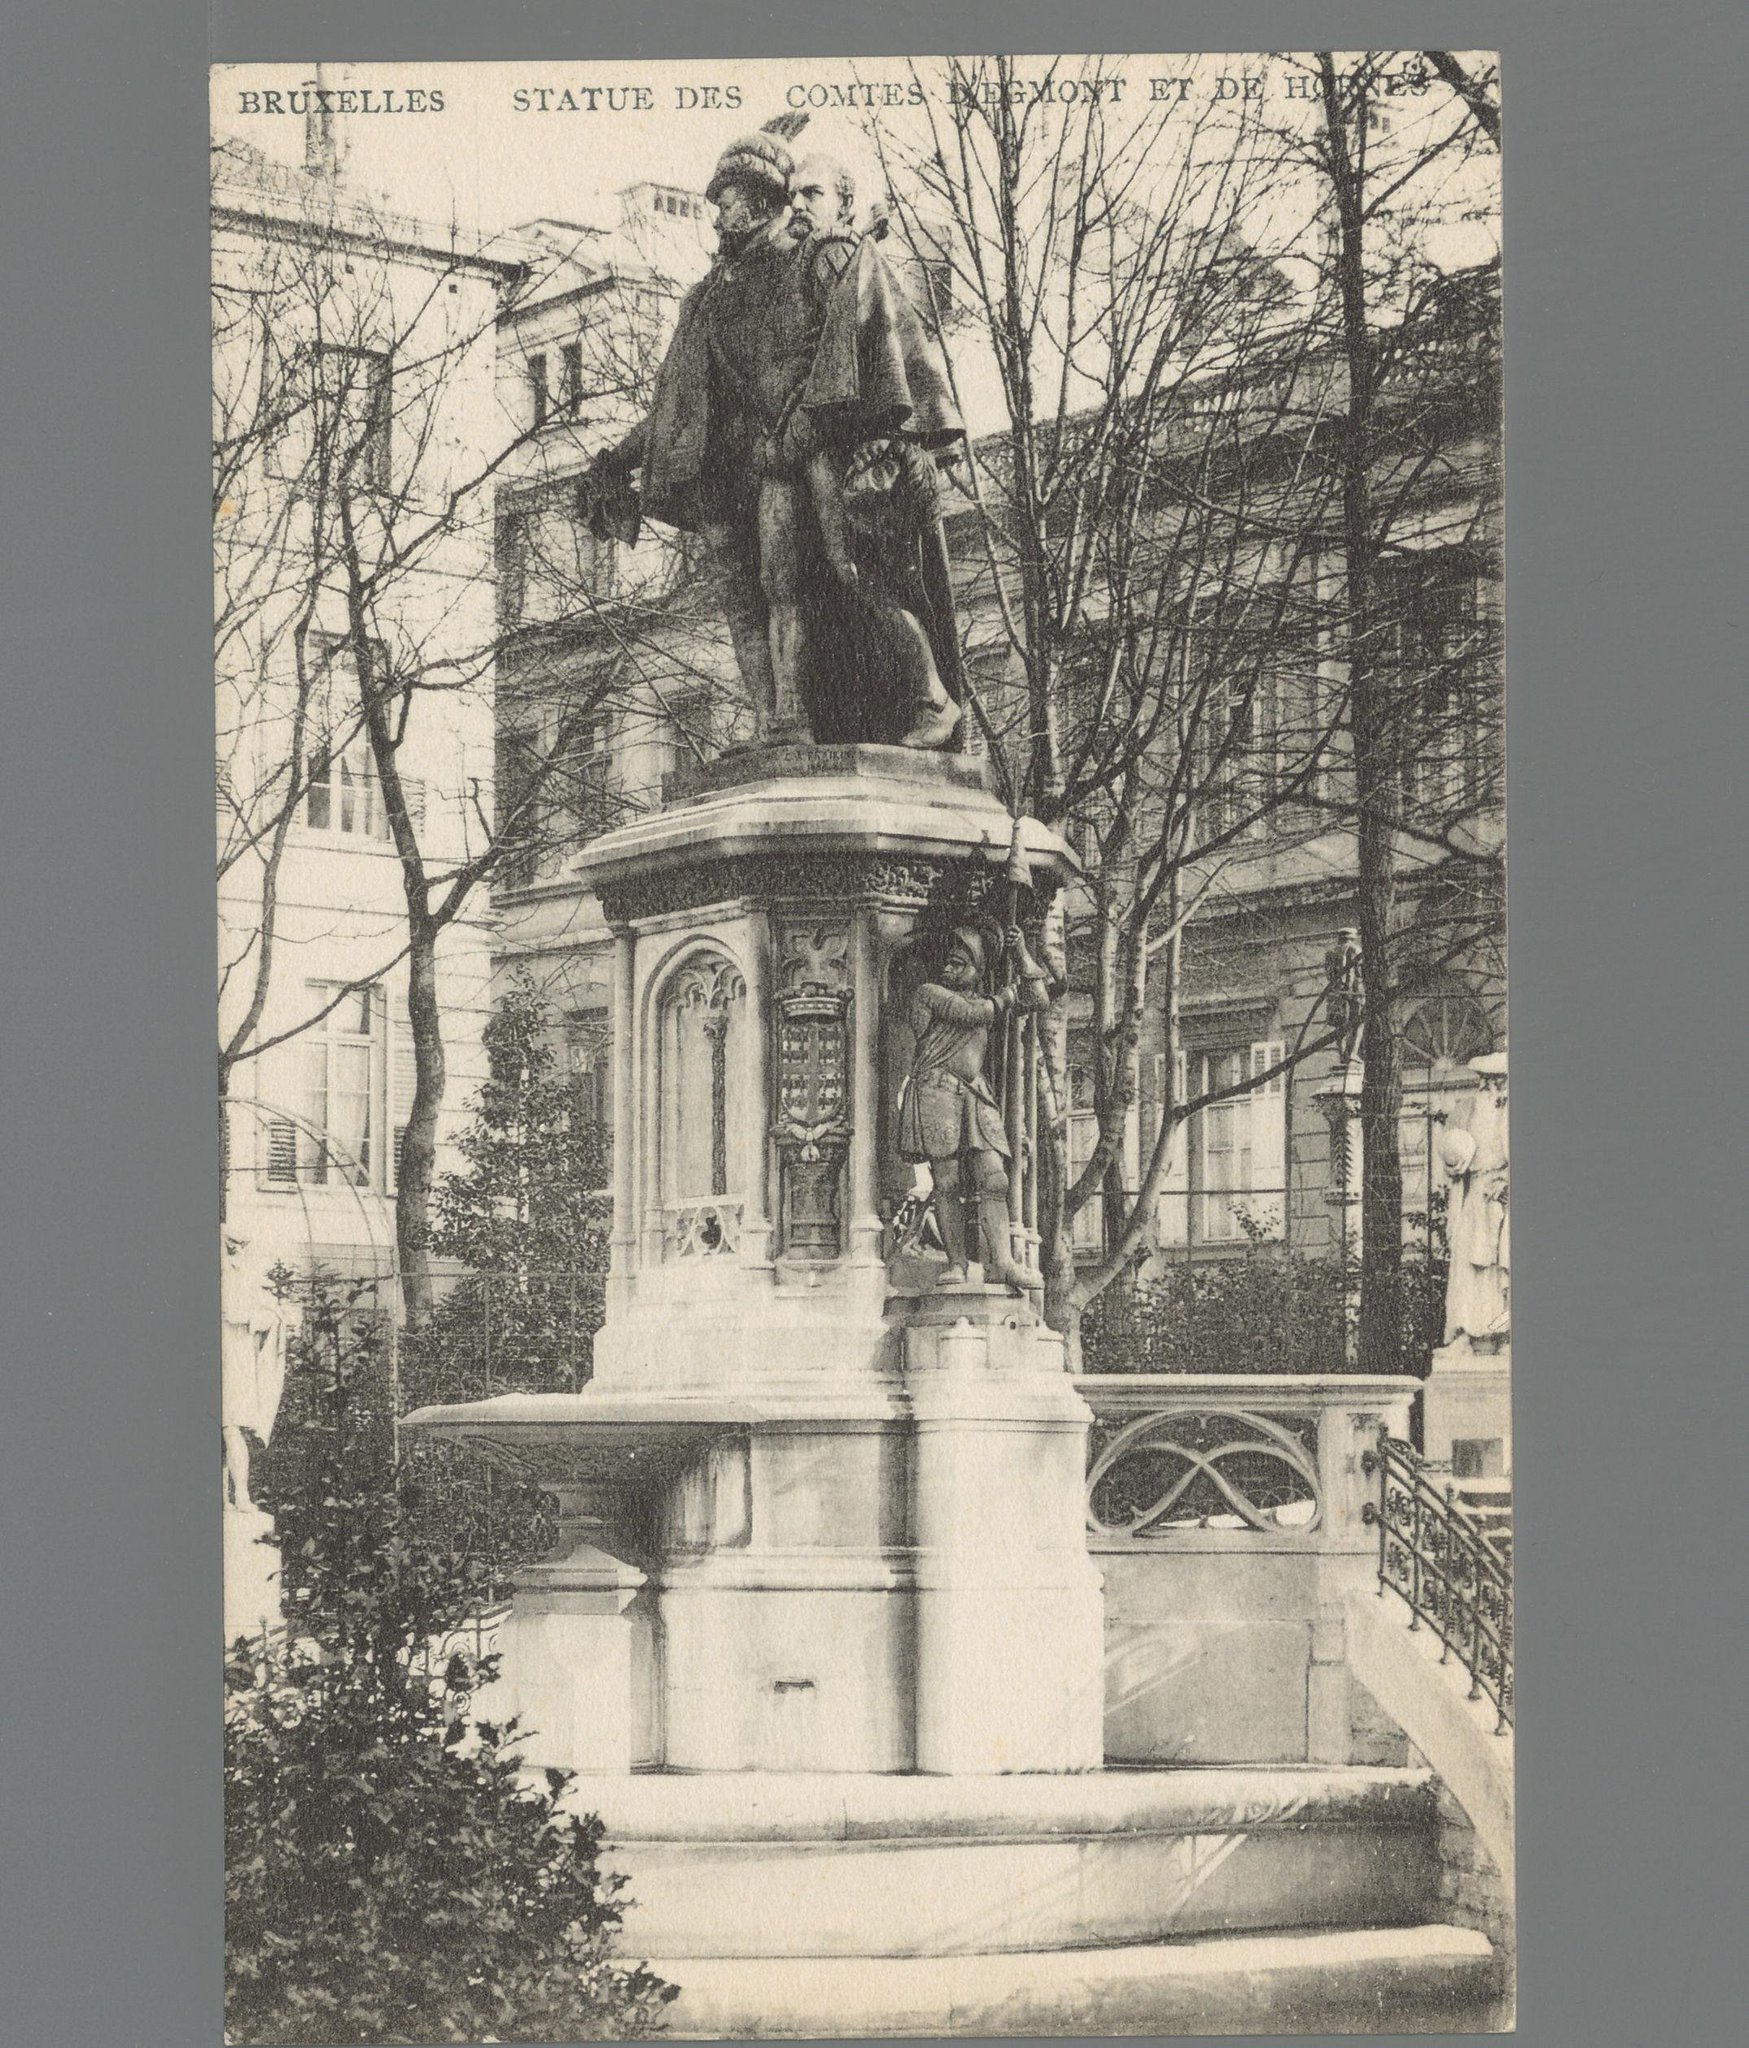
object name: ansichtkaart, prentbriefkaart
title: Bruxelles. Statue des Comtes d'Egmont et de Hornes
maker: Anonymous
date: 1906-1930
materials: cardboard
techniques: photograph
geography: brussels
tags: brussels, park, monument, statue